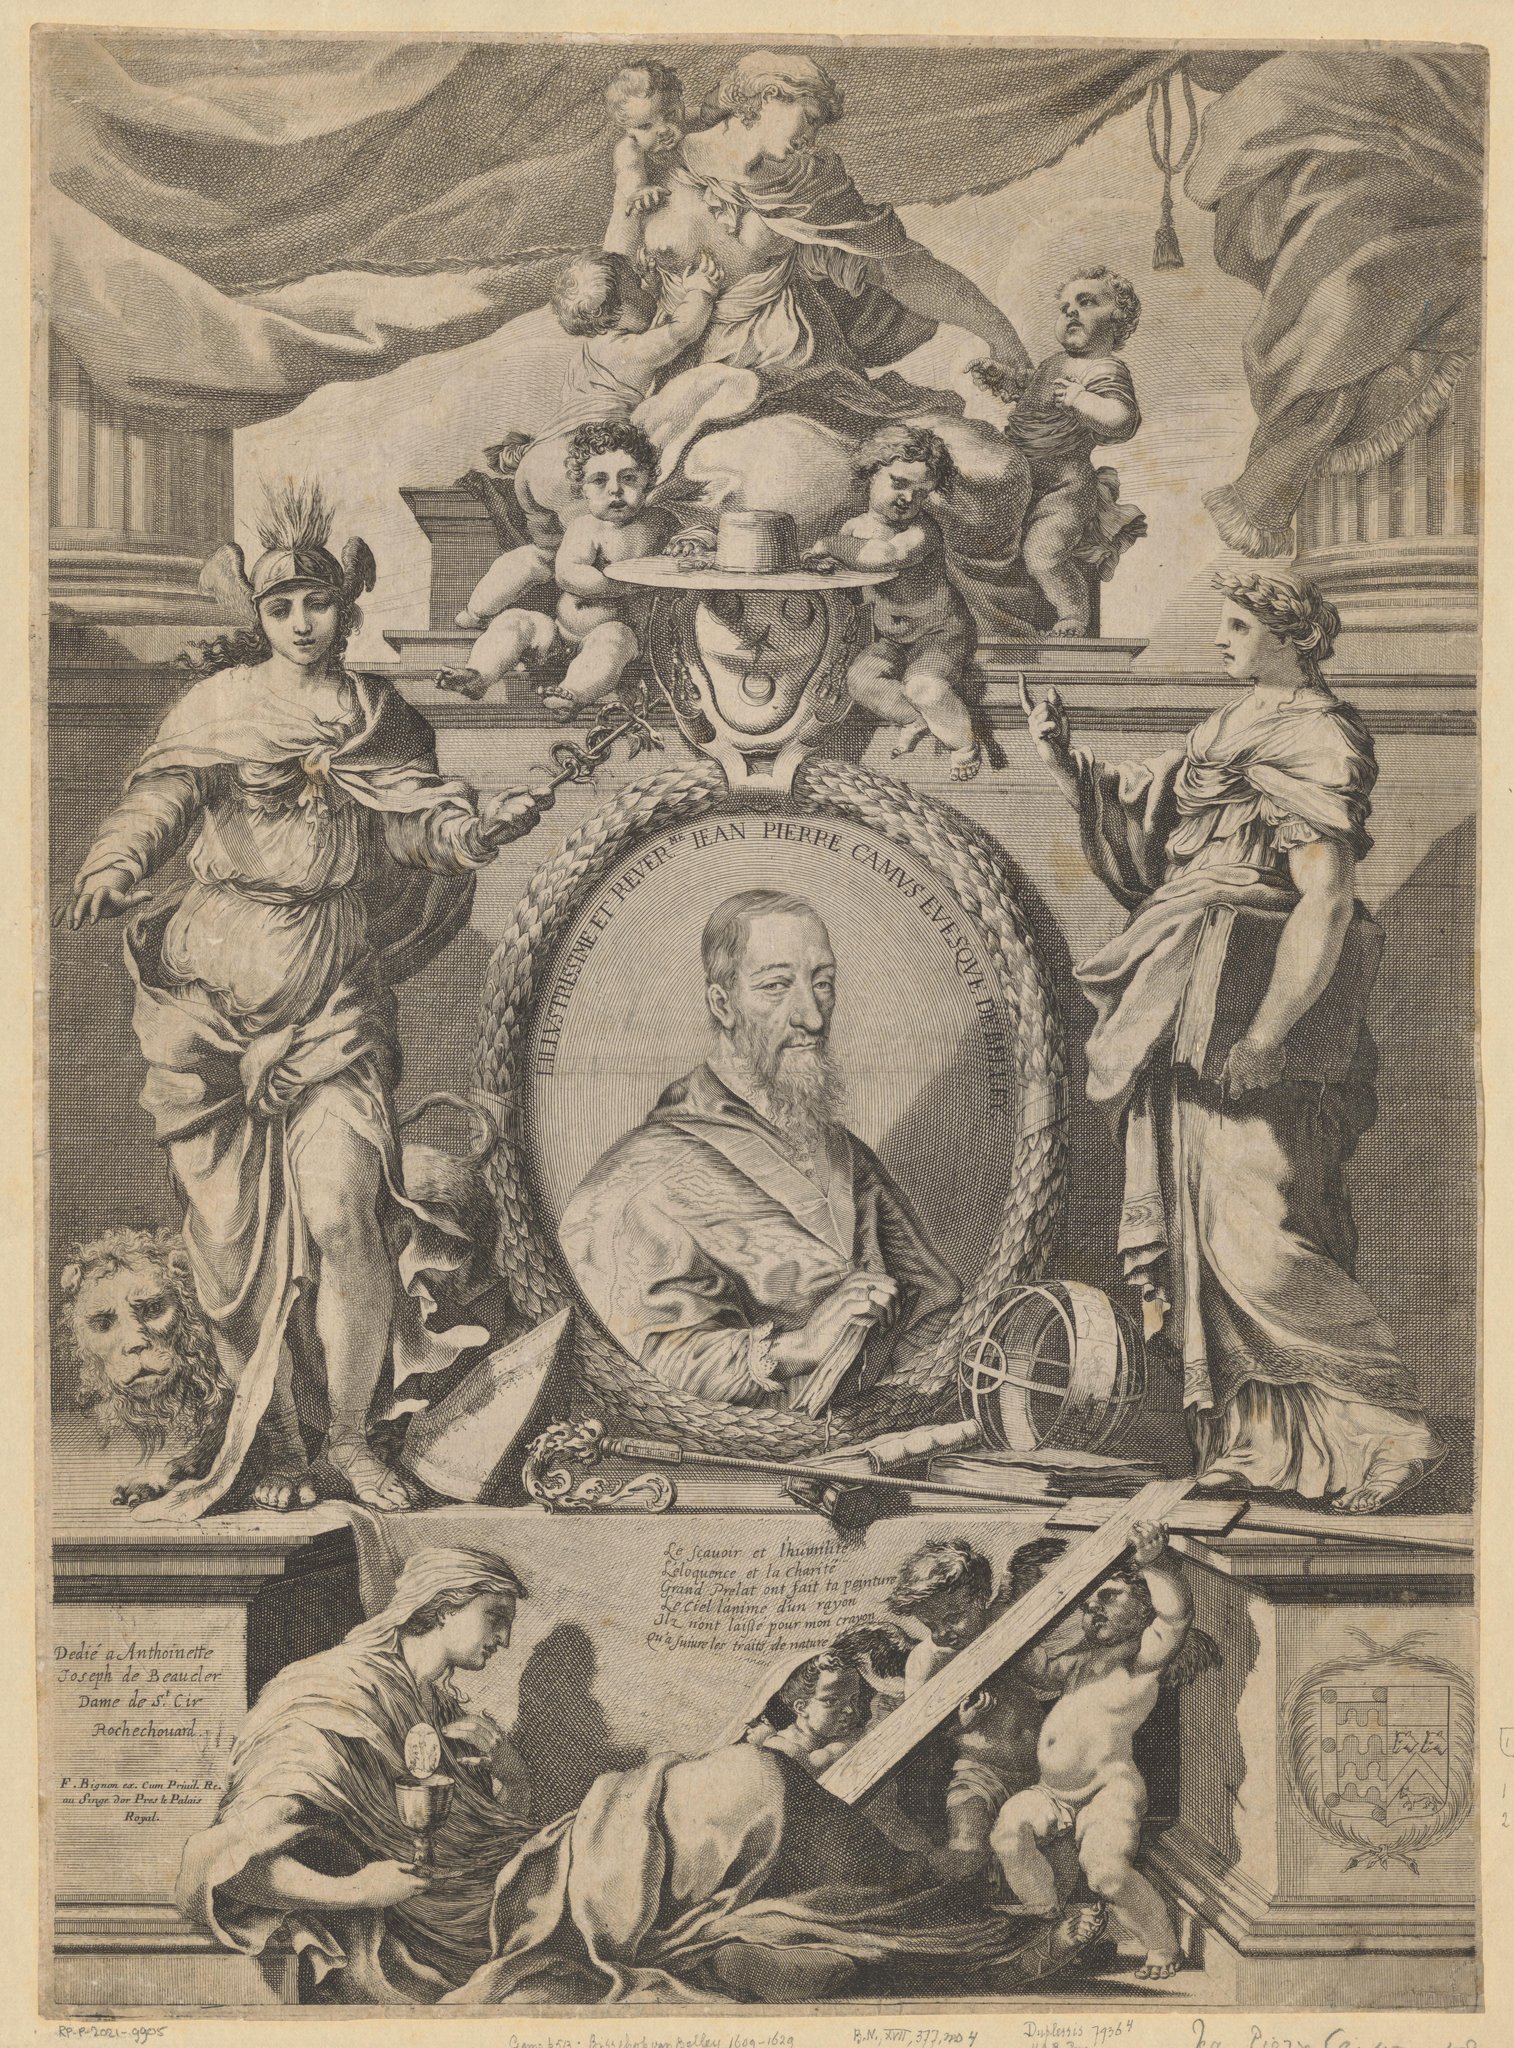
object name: print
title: Portret van Jean Pierre Camus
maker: françois bignon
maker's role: print maker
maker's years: 1620-1671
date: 1630-1671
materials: paper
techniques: engraving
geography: paris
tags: paris, charity, 'caritas'; 'carità' (ripa) ~ one of the three theological virtues, faith, 'fides'; 'fede', 'fede catholica', 'fede christiana', 'fede christiana catholica' (ripa) ~ one of the three theological virtues, historical persons, armorial bearing, heraldry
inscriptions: collector's mark: Lugt 240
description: Onder het portret een zesregelig vers. Rechtsonder zijn wapenschild.